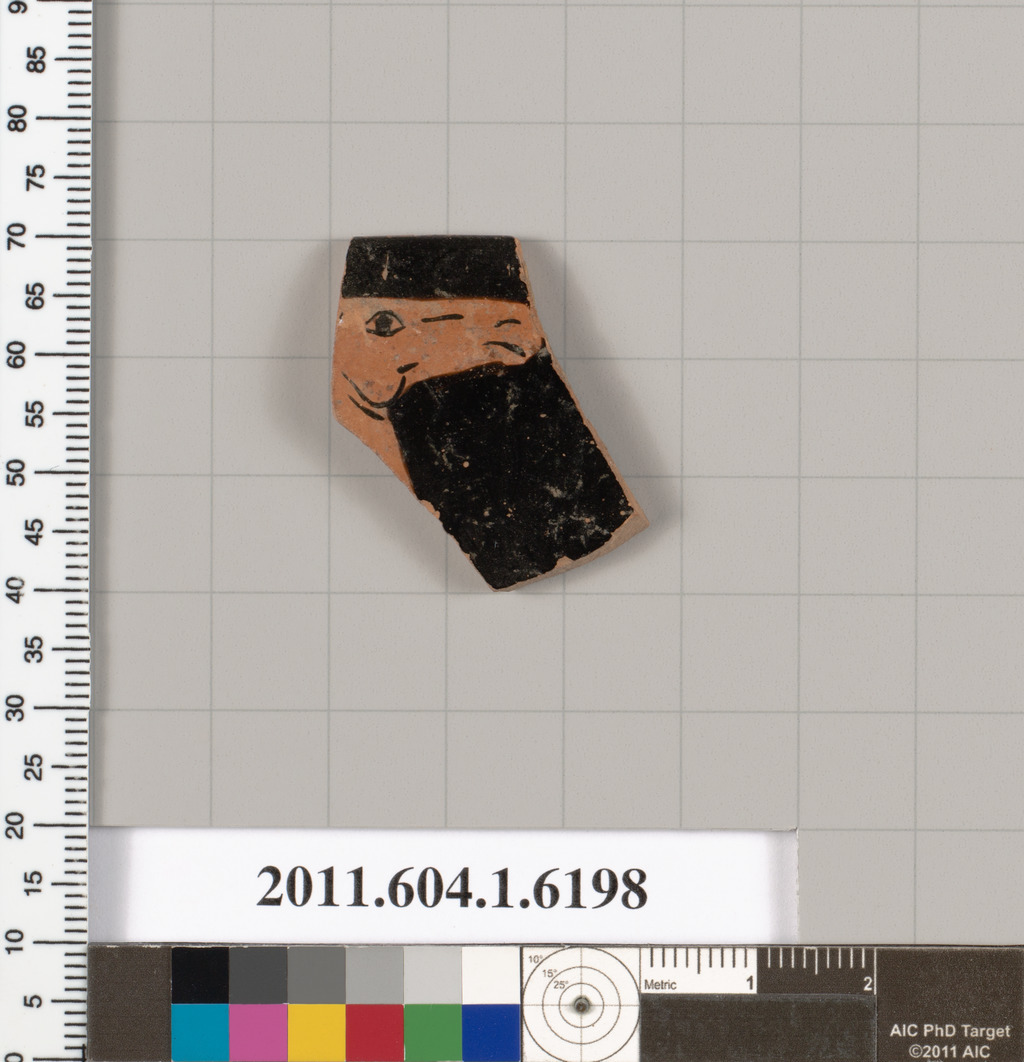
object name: kylix fragment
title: Terracotta rim fragment of a kylix (drinking cup)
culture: greek, attic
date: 510-500 BCE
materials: terracotta